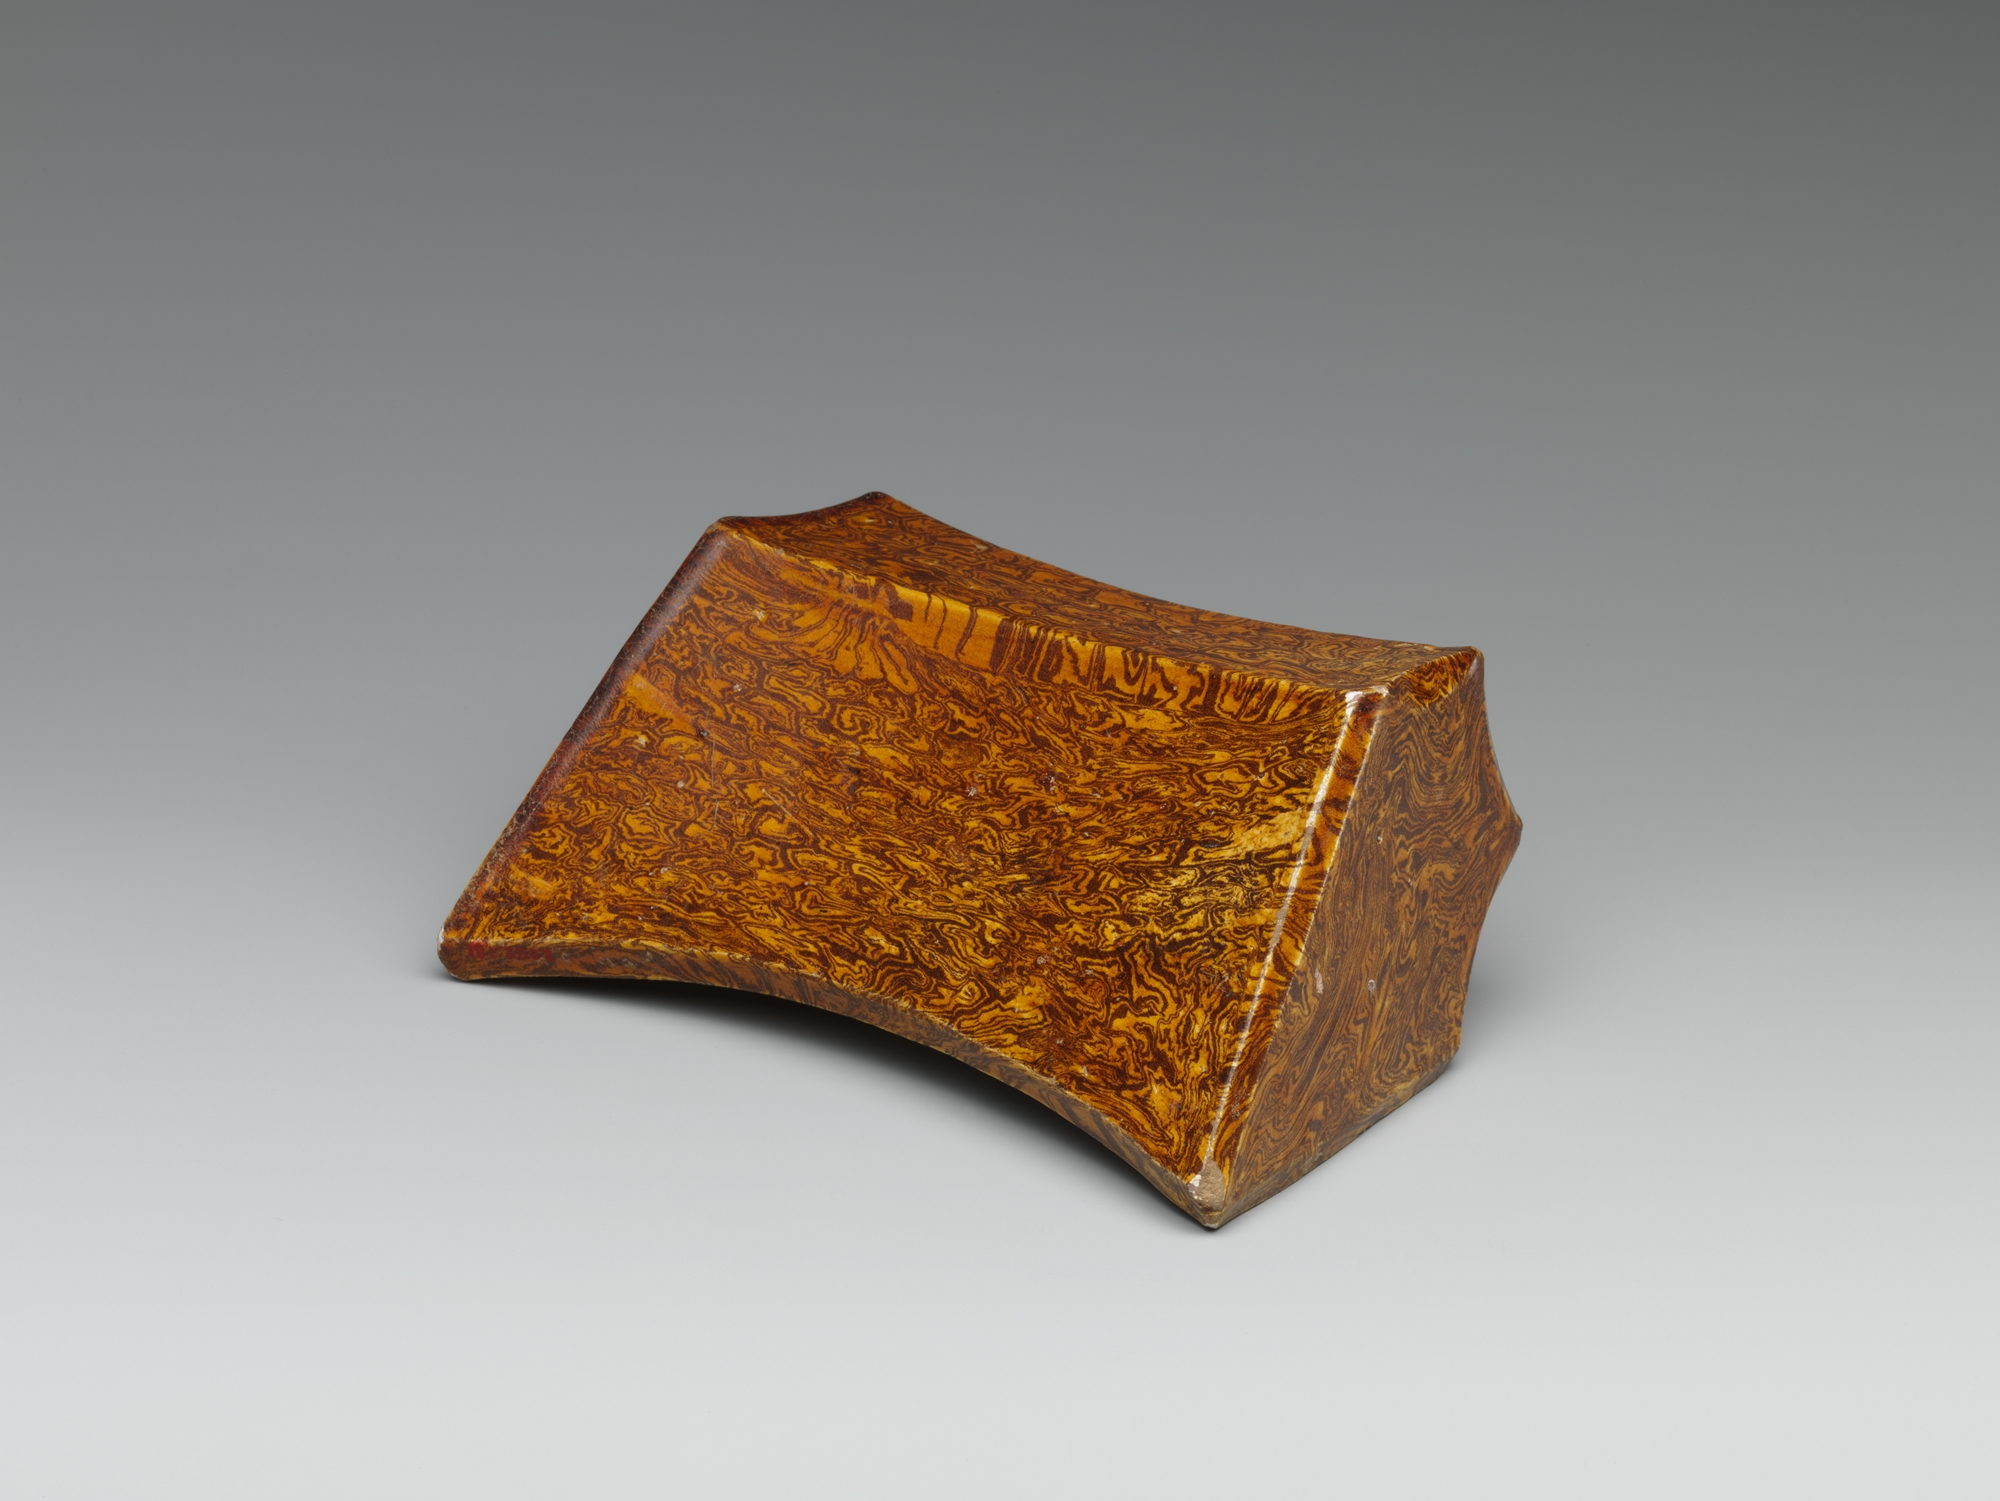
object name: pillow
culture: chinese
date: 700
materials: earthenware, glaze, marble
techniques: veneering